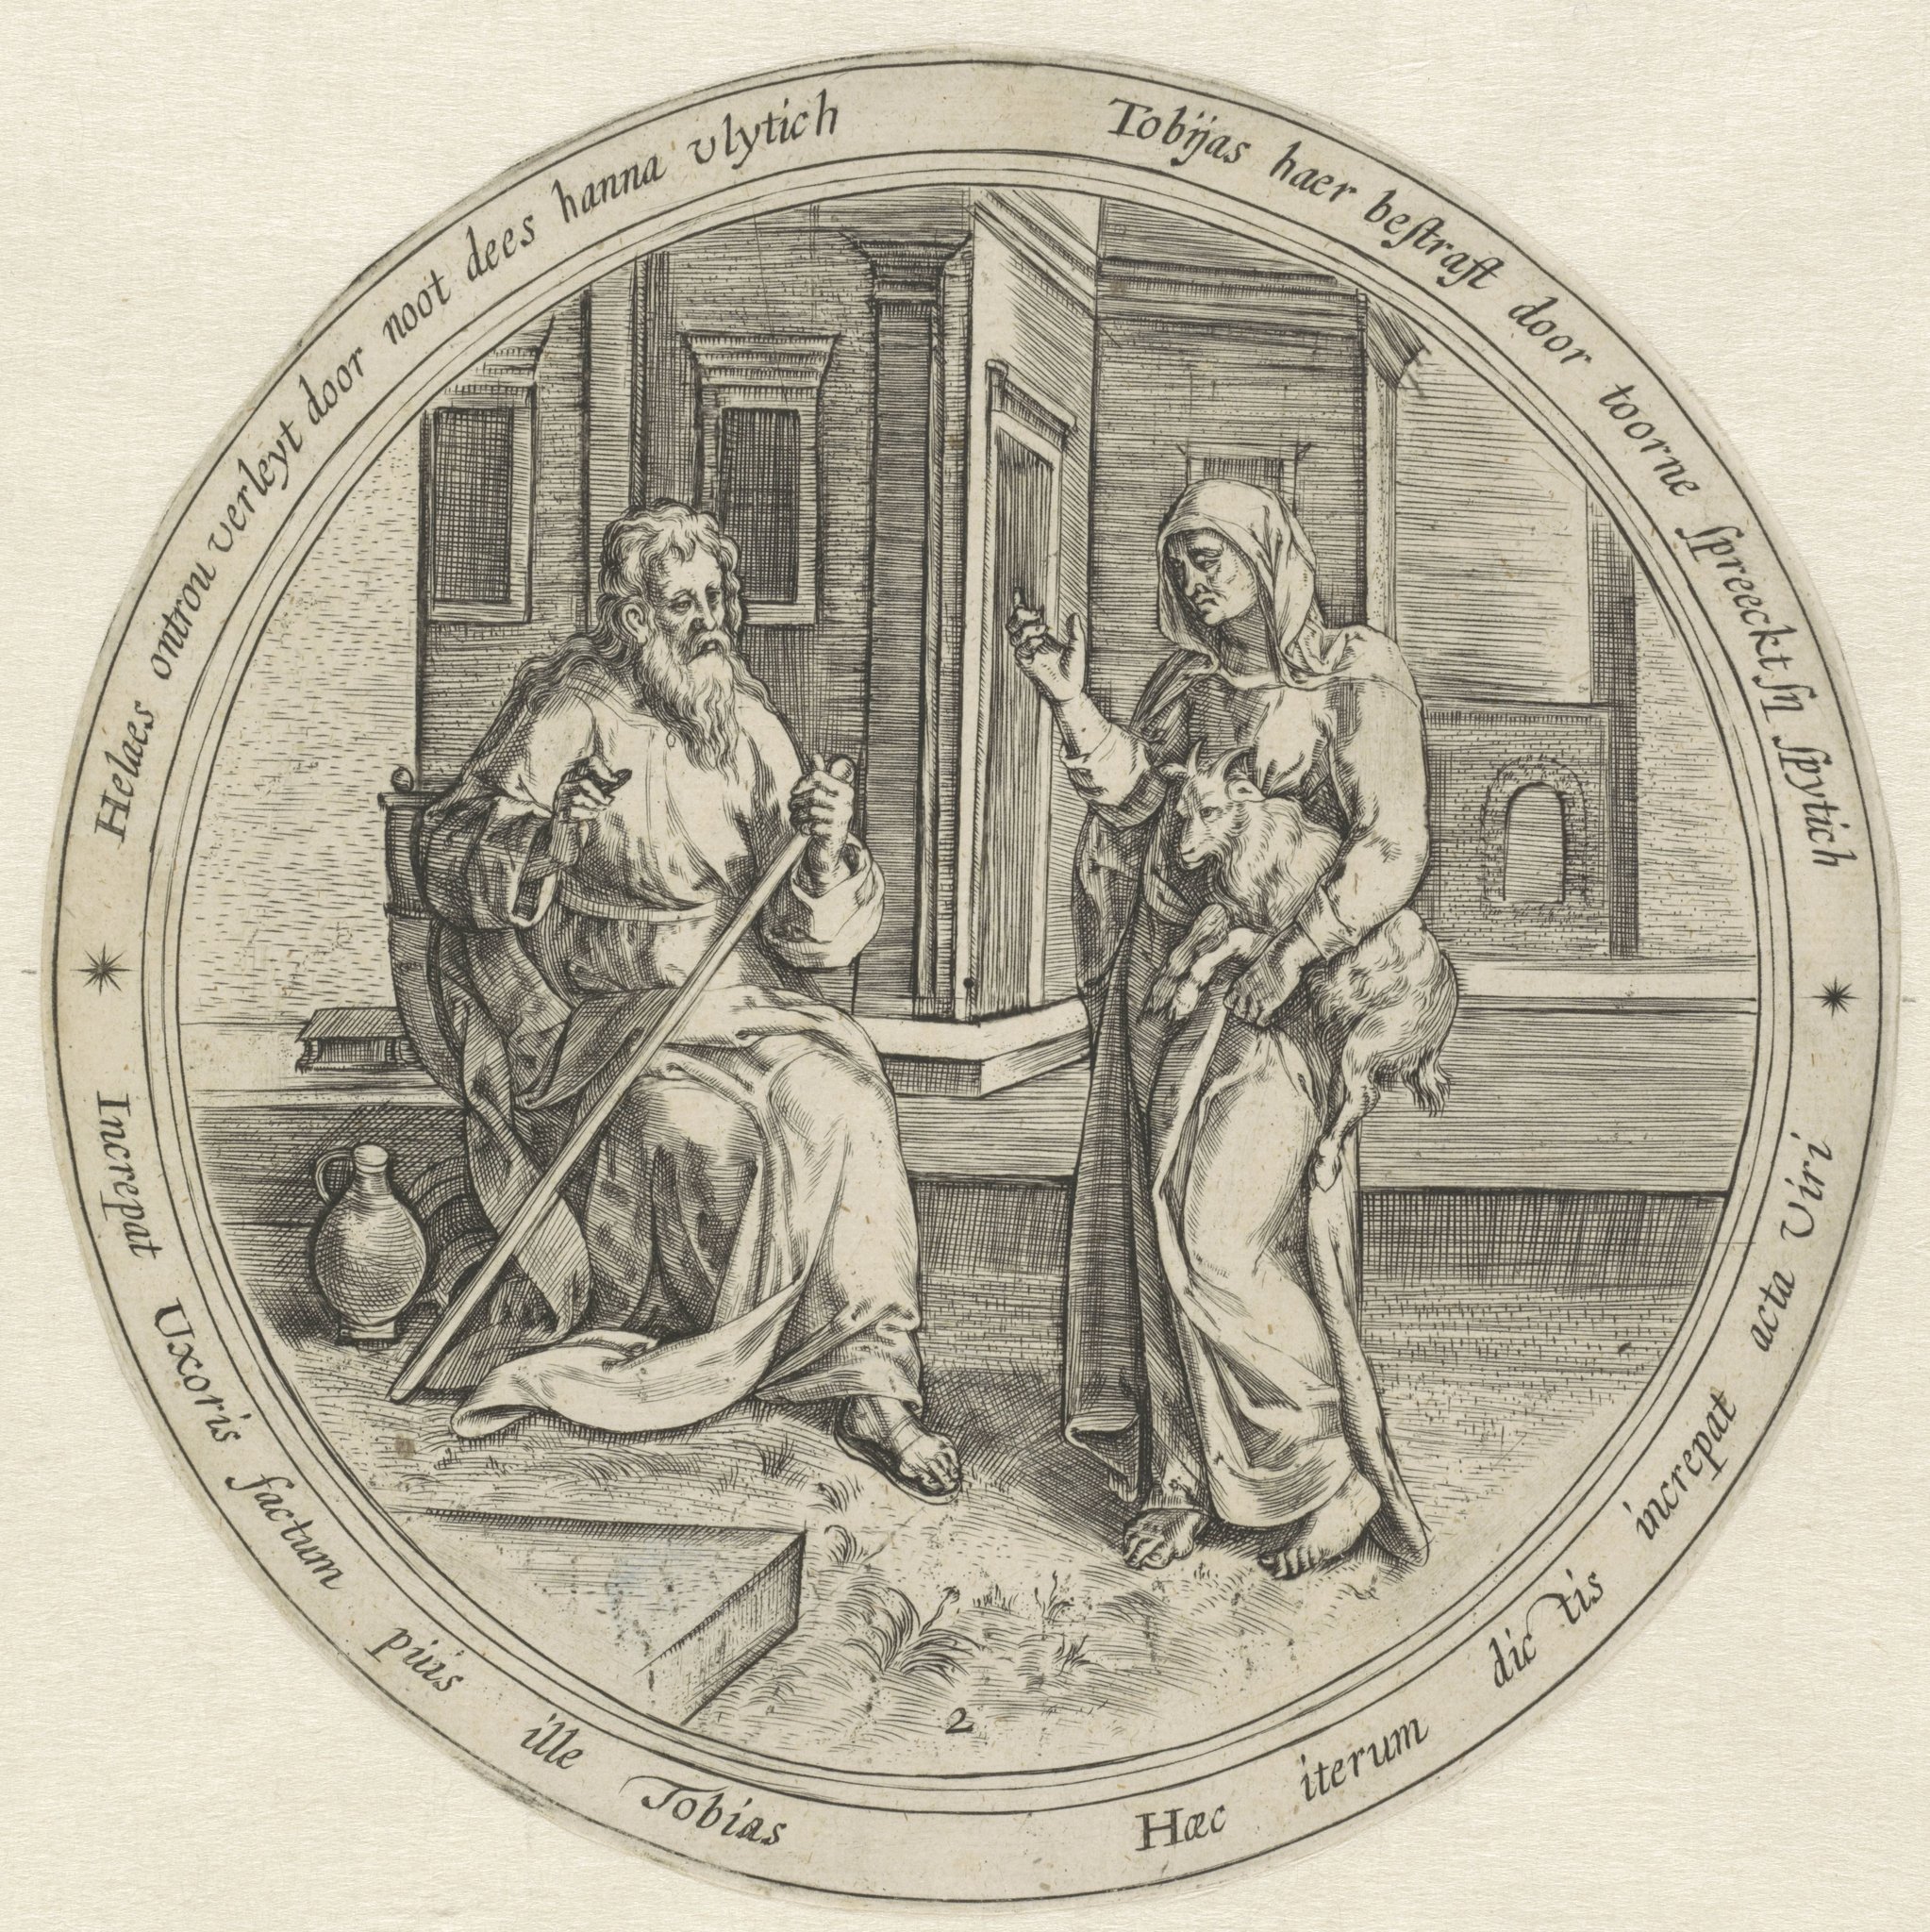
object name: print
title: Geschiedenis van Tobias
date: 1601-1652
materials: paper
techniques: engraving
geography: amsterdam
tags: anna brings home a young goat: tobit thinks she has stolen it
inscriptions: collector's mark: Lugt 1403b, collector's mark: Lugt 2228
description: Naast haar loon krijgt Anna als beloning een jong geitje mee naar huis. Anna staat met het geitje onder de arm voor haar blinde man Tobit, die denkt dat zij het heeft gestolen. Rond de voorstelling een randschrift in het Nederlands en in het Latijn.